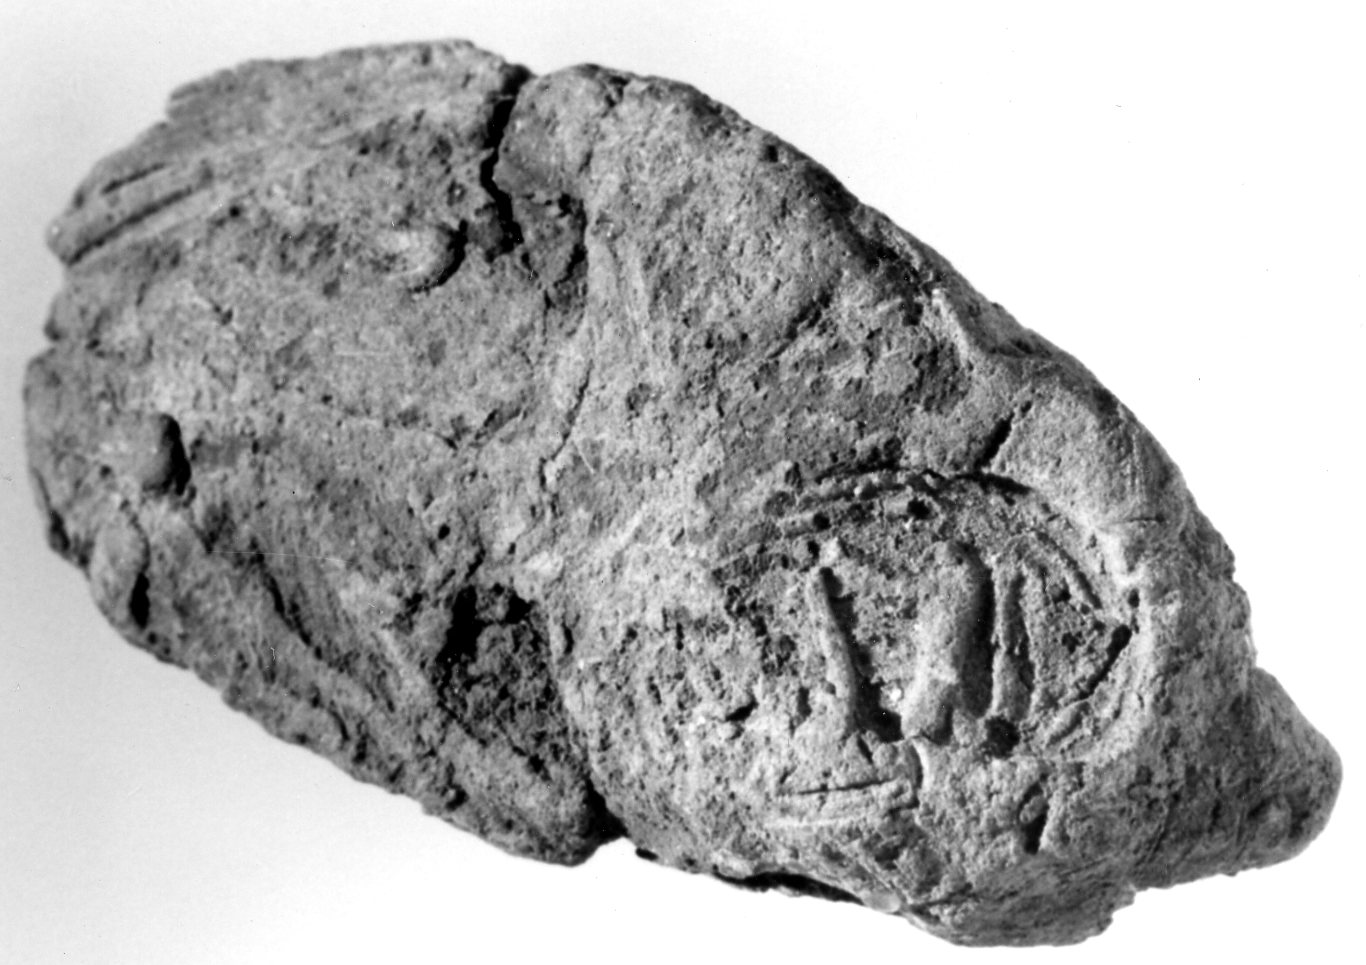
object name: sealing, amenhotep iii, nebmaatre. winged cobra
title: Document Sealing with the Throne Name of Amenhotep III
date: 1390-1352 BCE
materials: mud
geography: egypt